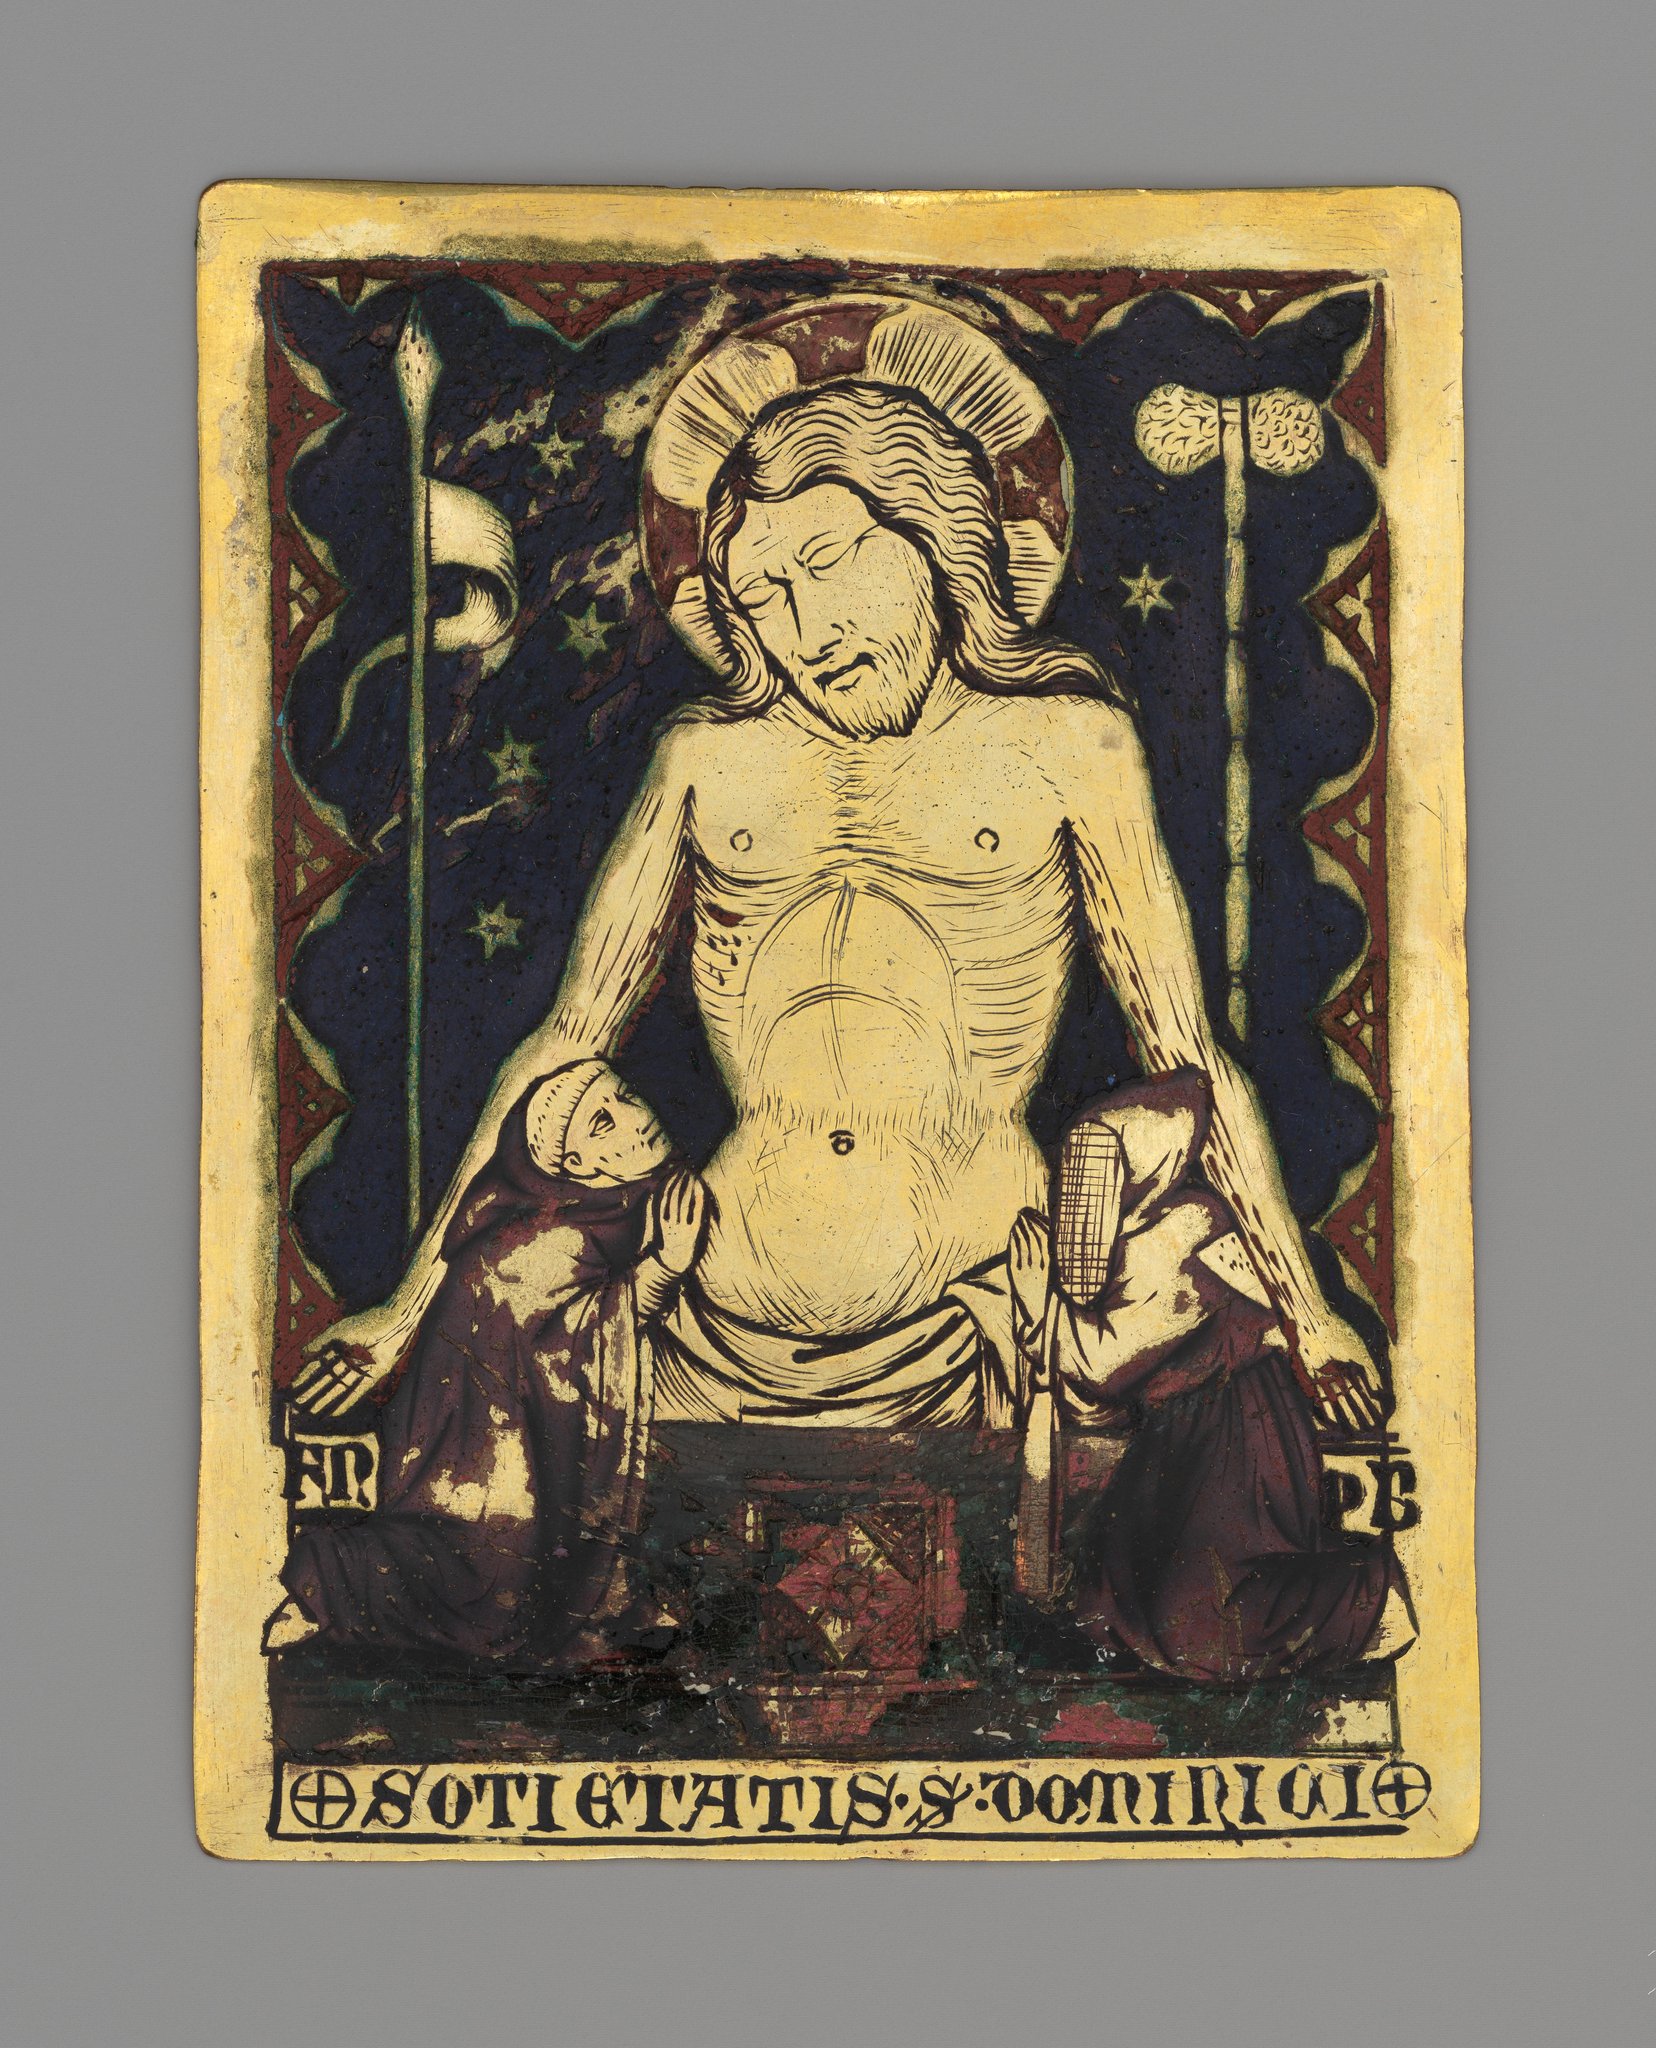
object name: plaque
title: The Man of Sorrows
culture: italian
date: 1376-1400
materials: enamel, gilt copper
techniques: enamel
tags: christ